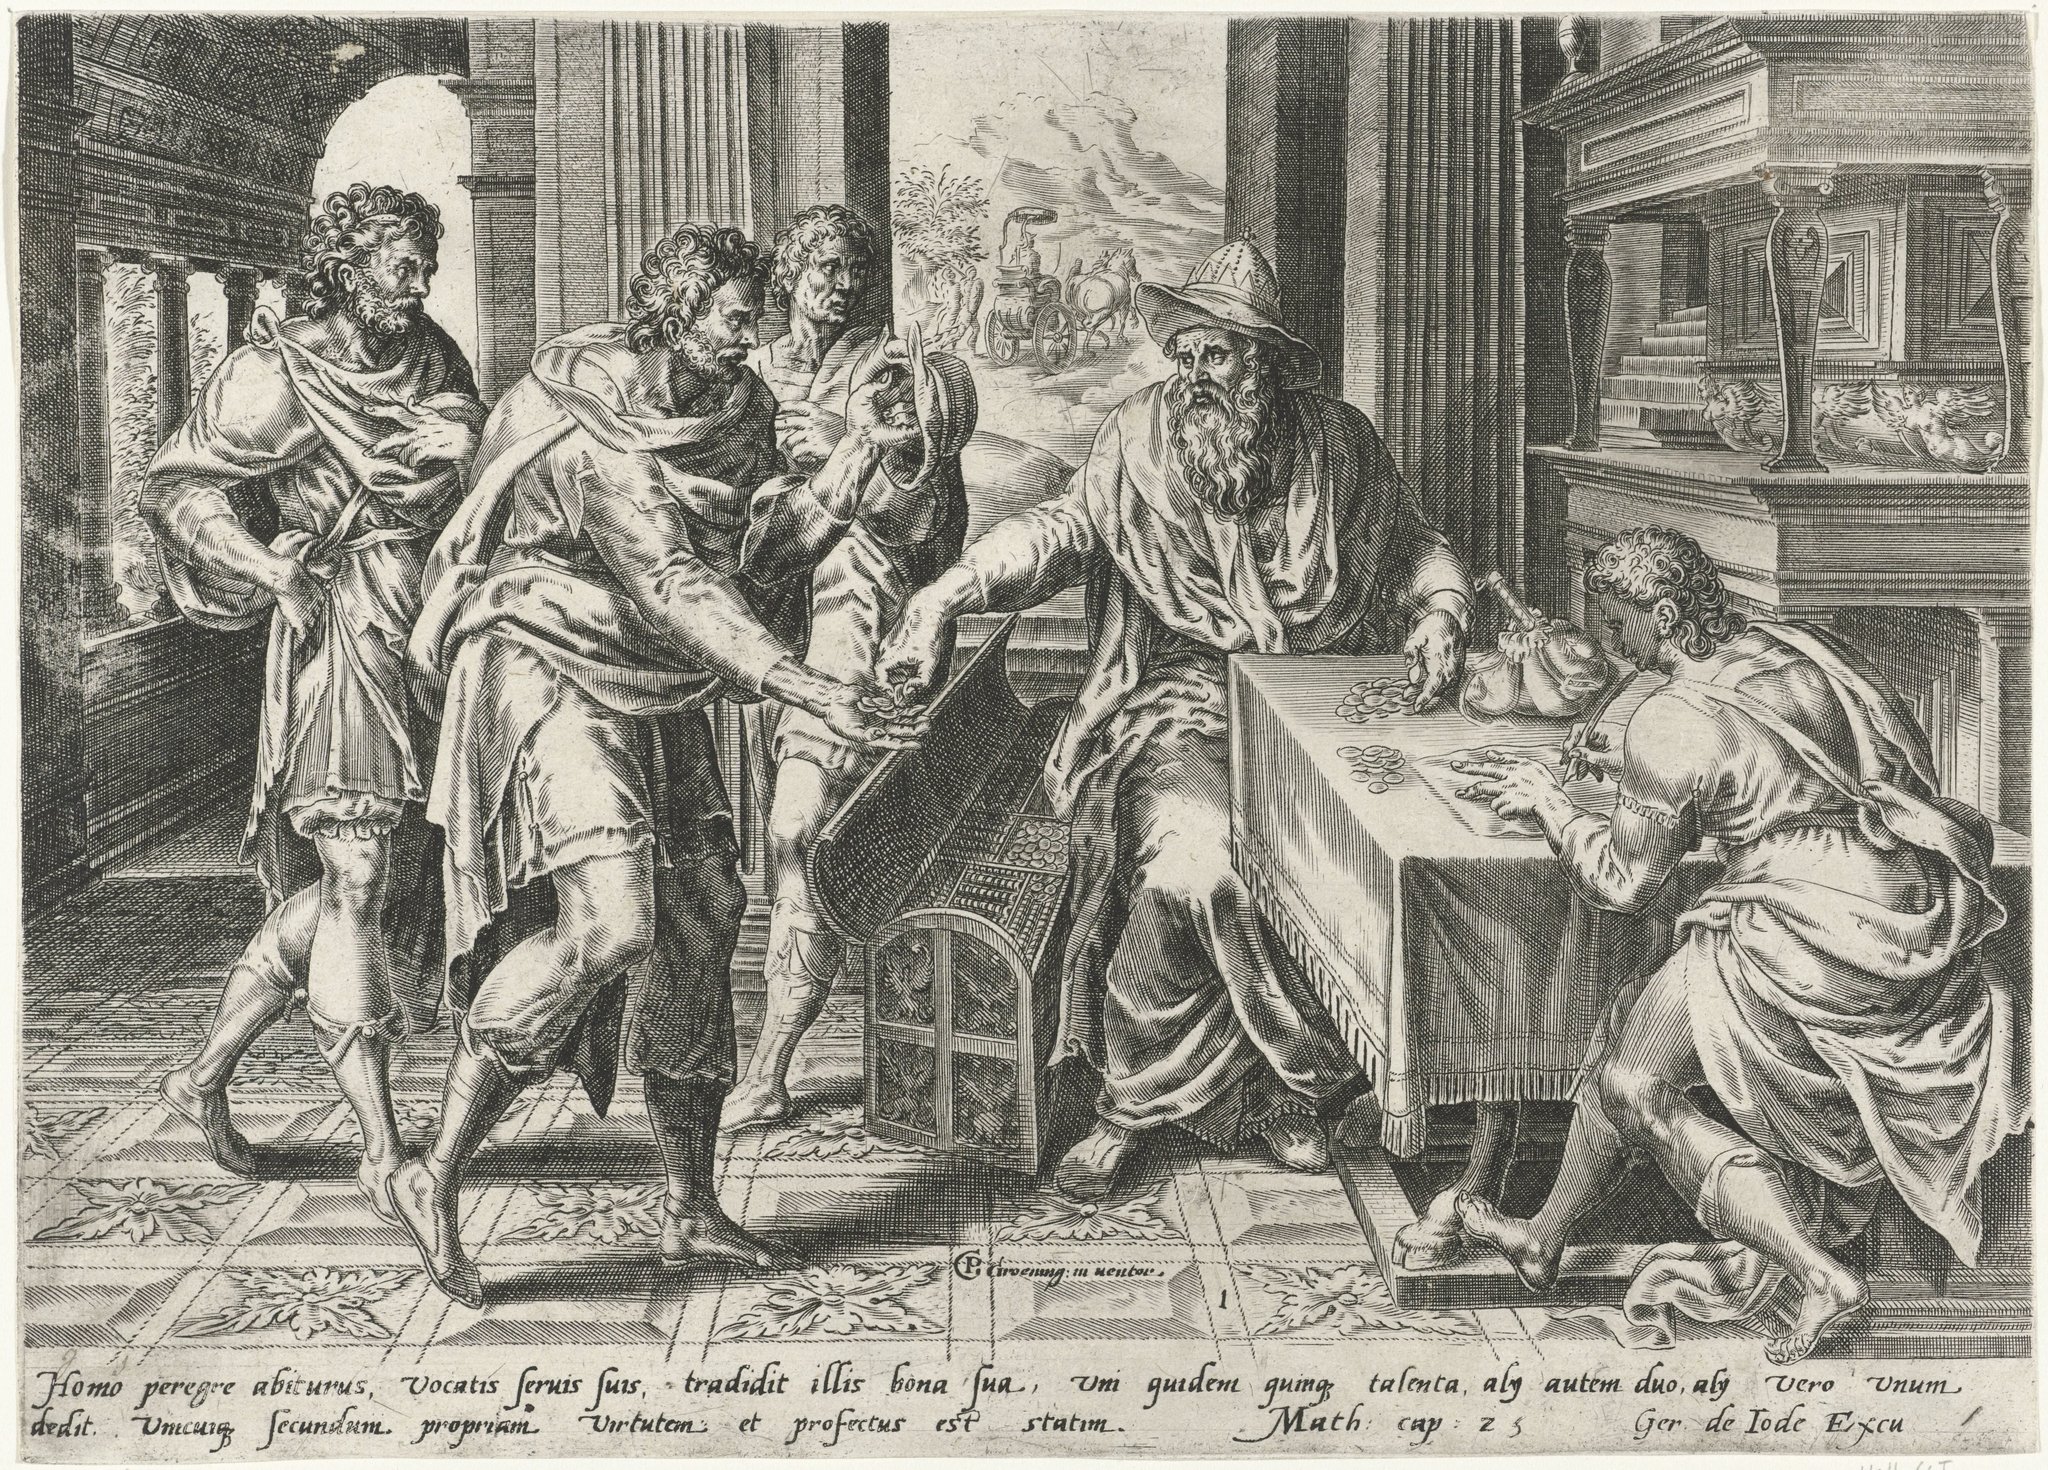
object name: print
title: Man geeft talenten aan zijn dienaren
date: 1565-1572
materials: paper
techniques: engraving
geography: amsterdam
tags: the lord distributing talents or pounds among his servants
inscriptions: collector's mark: Lugt 2228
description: Een man bij een tafel geeft voor hij op reis gaat zijn geld in het bezit van drie dienaren. Aan de eerste geeft hij vijf talent. Achter hem wachten de andere twee. Een secretaris tekent de bedragen op. In de achtergrond vertrekt de man in zijn koets. Onderaan in de marge een verwijzing naar de Bijbeltekst in het Latijn.